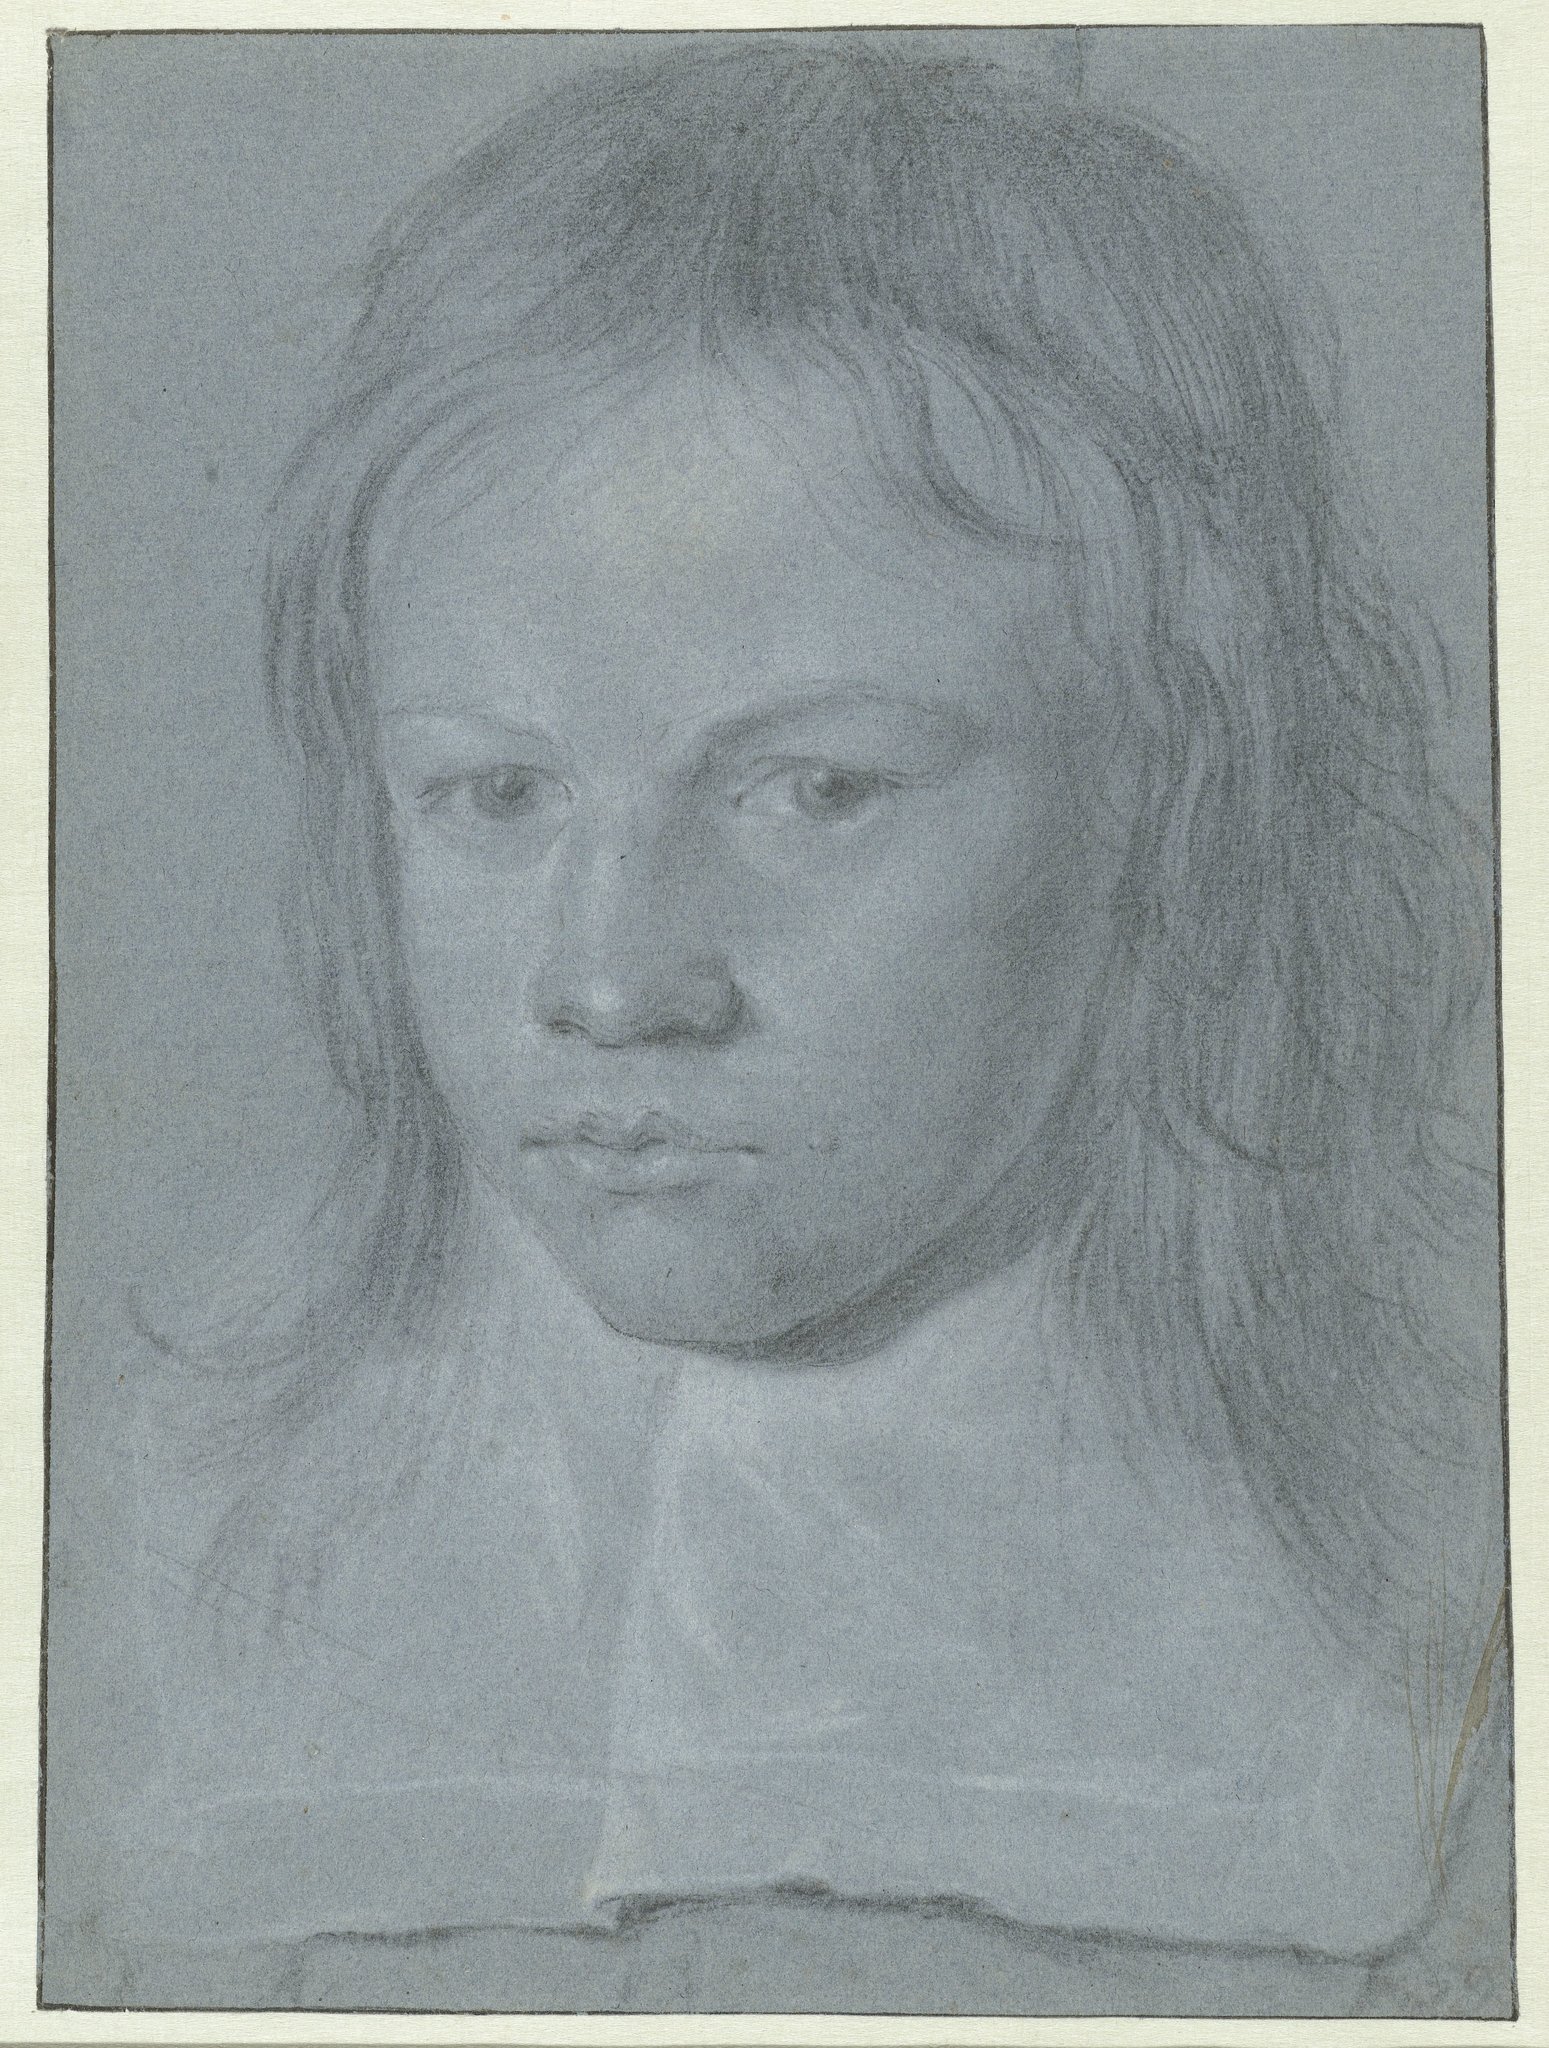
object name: drawing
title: Jongenskop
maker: abraham toorenvliet (i)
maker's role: draughtsman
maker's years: 1640-1692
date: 1650-1692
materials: chalk, paper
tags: head (human), boy (child between toddler and youth)